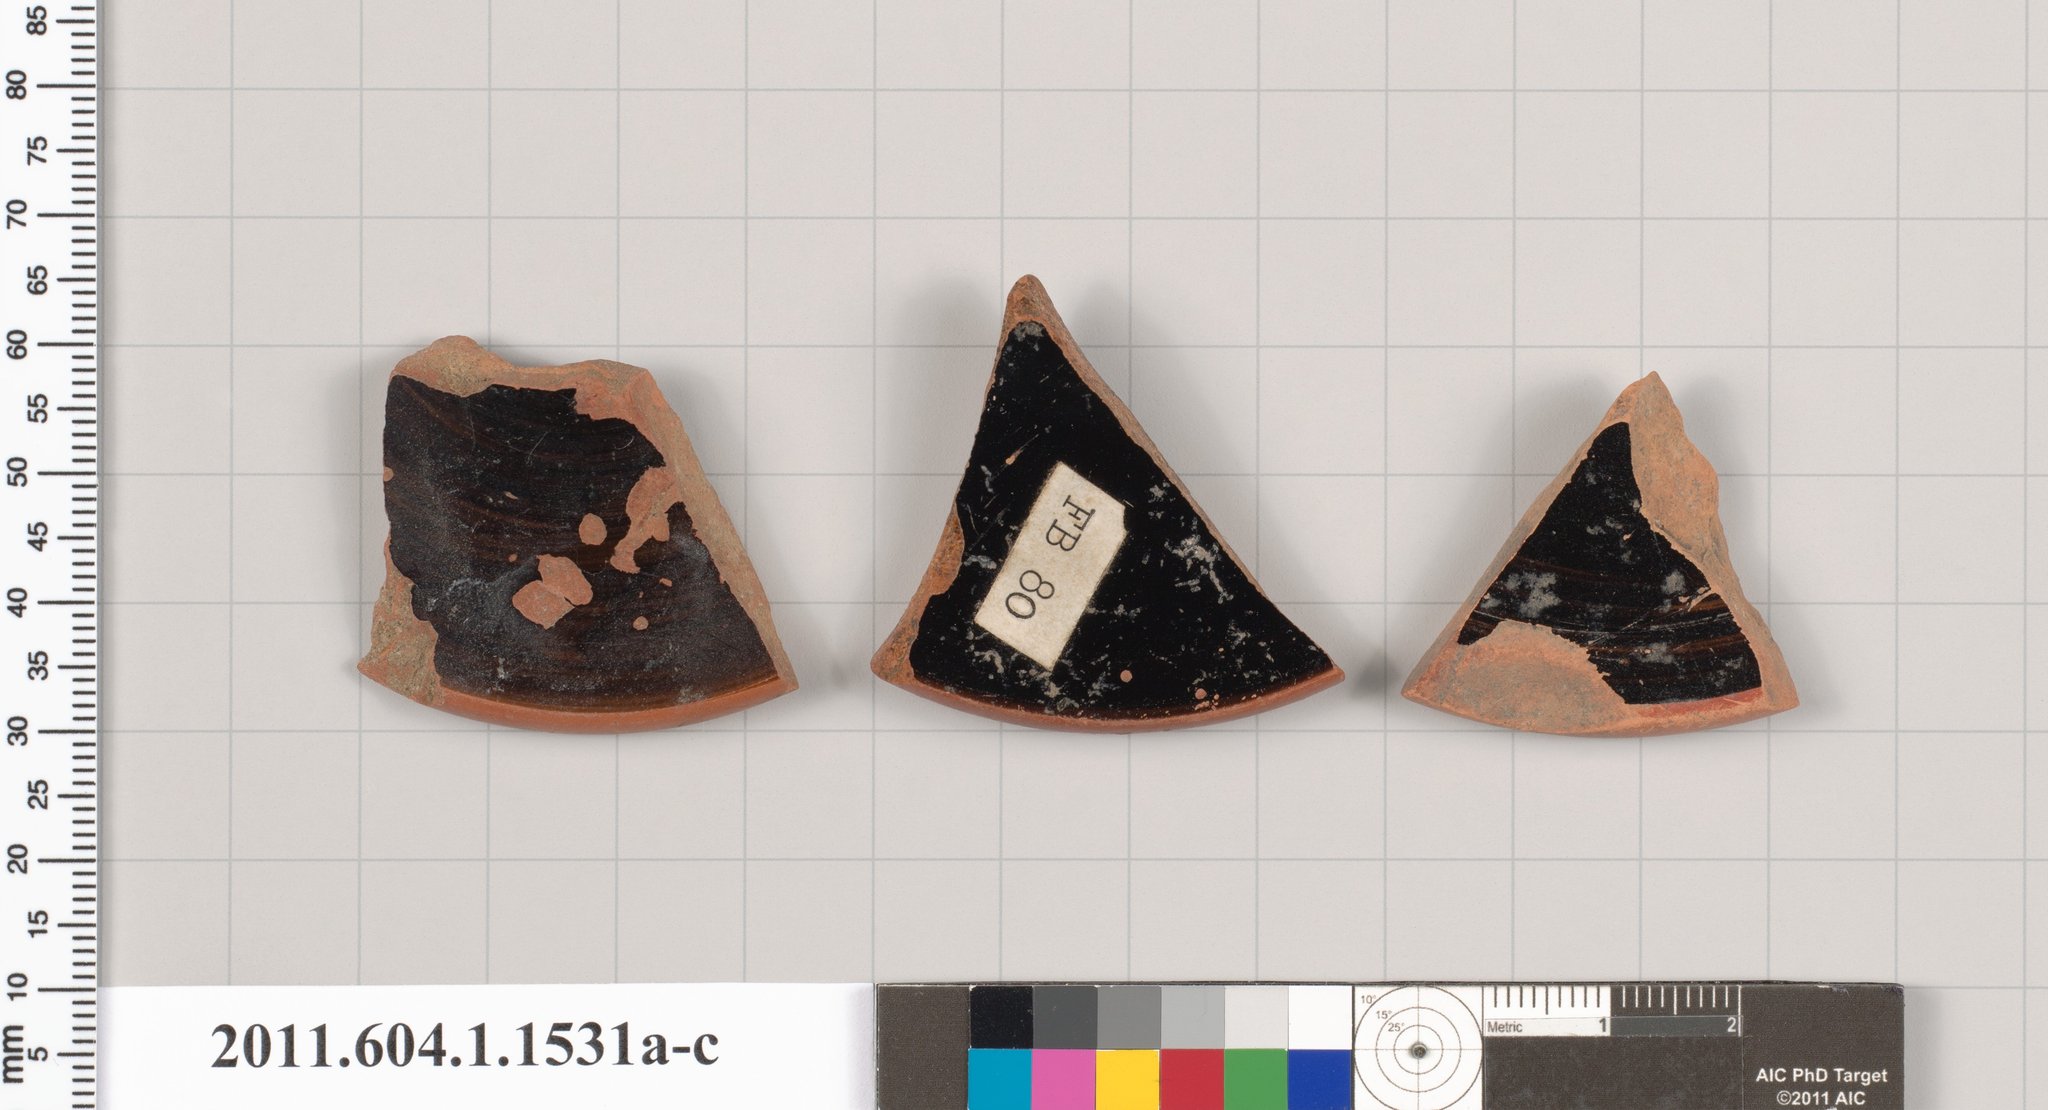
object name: kylix fragment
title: Terracotta fragments of kylikes (drinking cups)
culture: greek, attic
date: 500-401 BCE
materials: terracotta